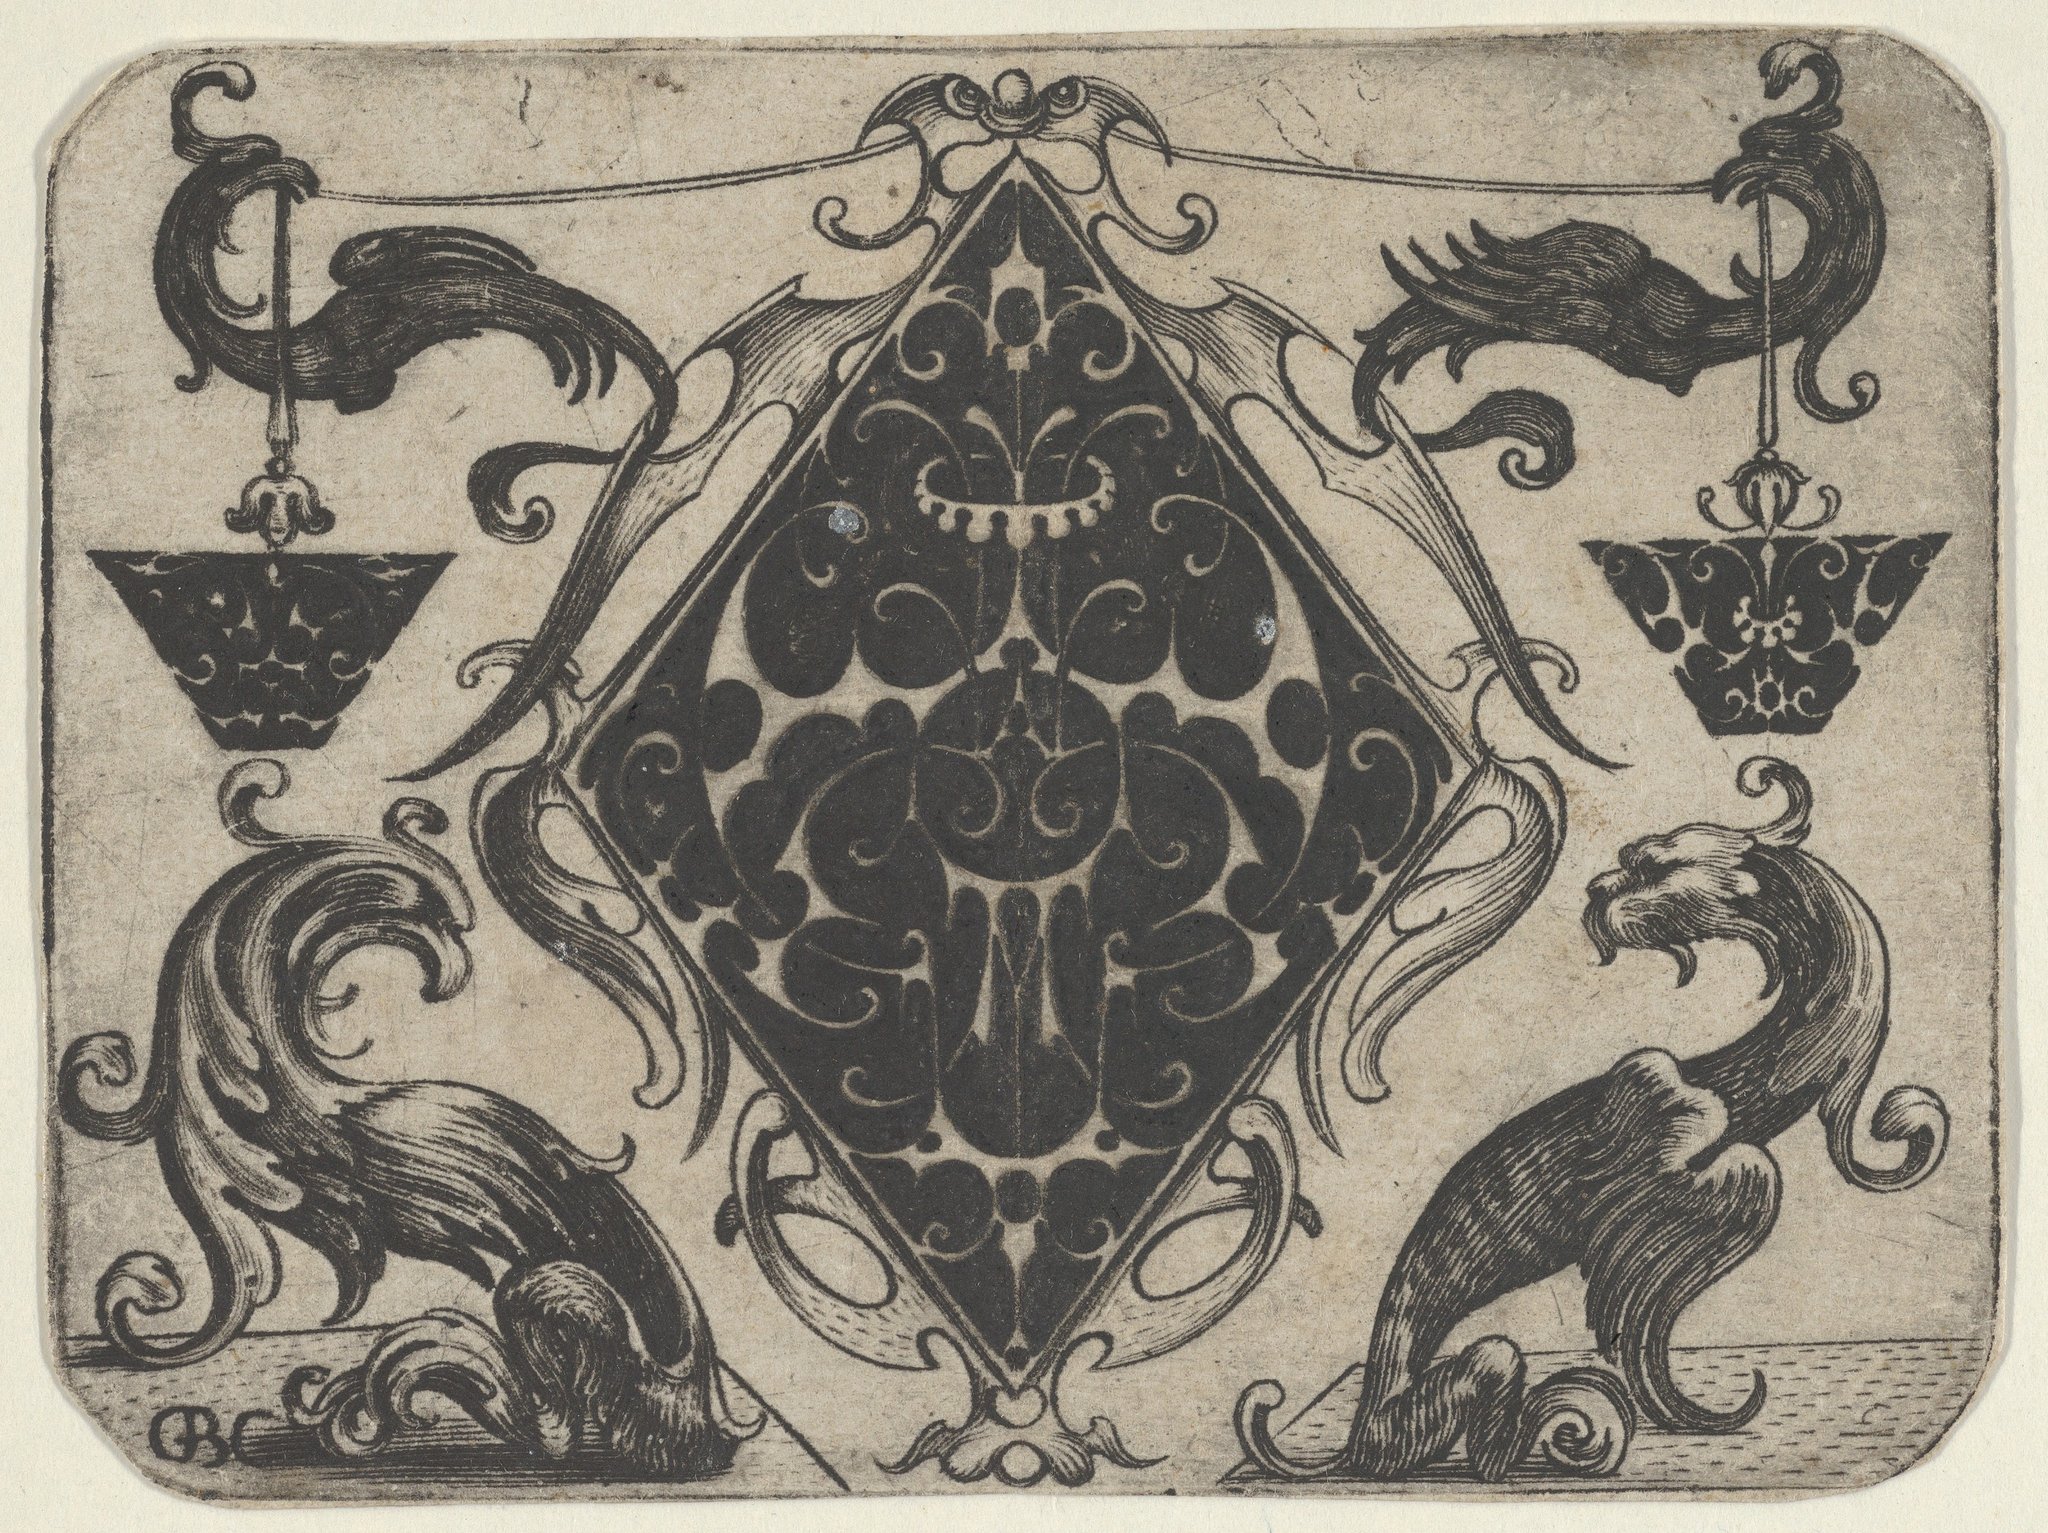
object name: print collection ornament architecture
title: Lozenge-shaped Pendant and Two Trapezoid Motifs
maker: giovanni battista costantini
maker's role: printmaker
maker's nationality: italian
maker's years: 1615-1628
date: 1622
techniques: embroidery, engraving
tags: pendants